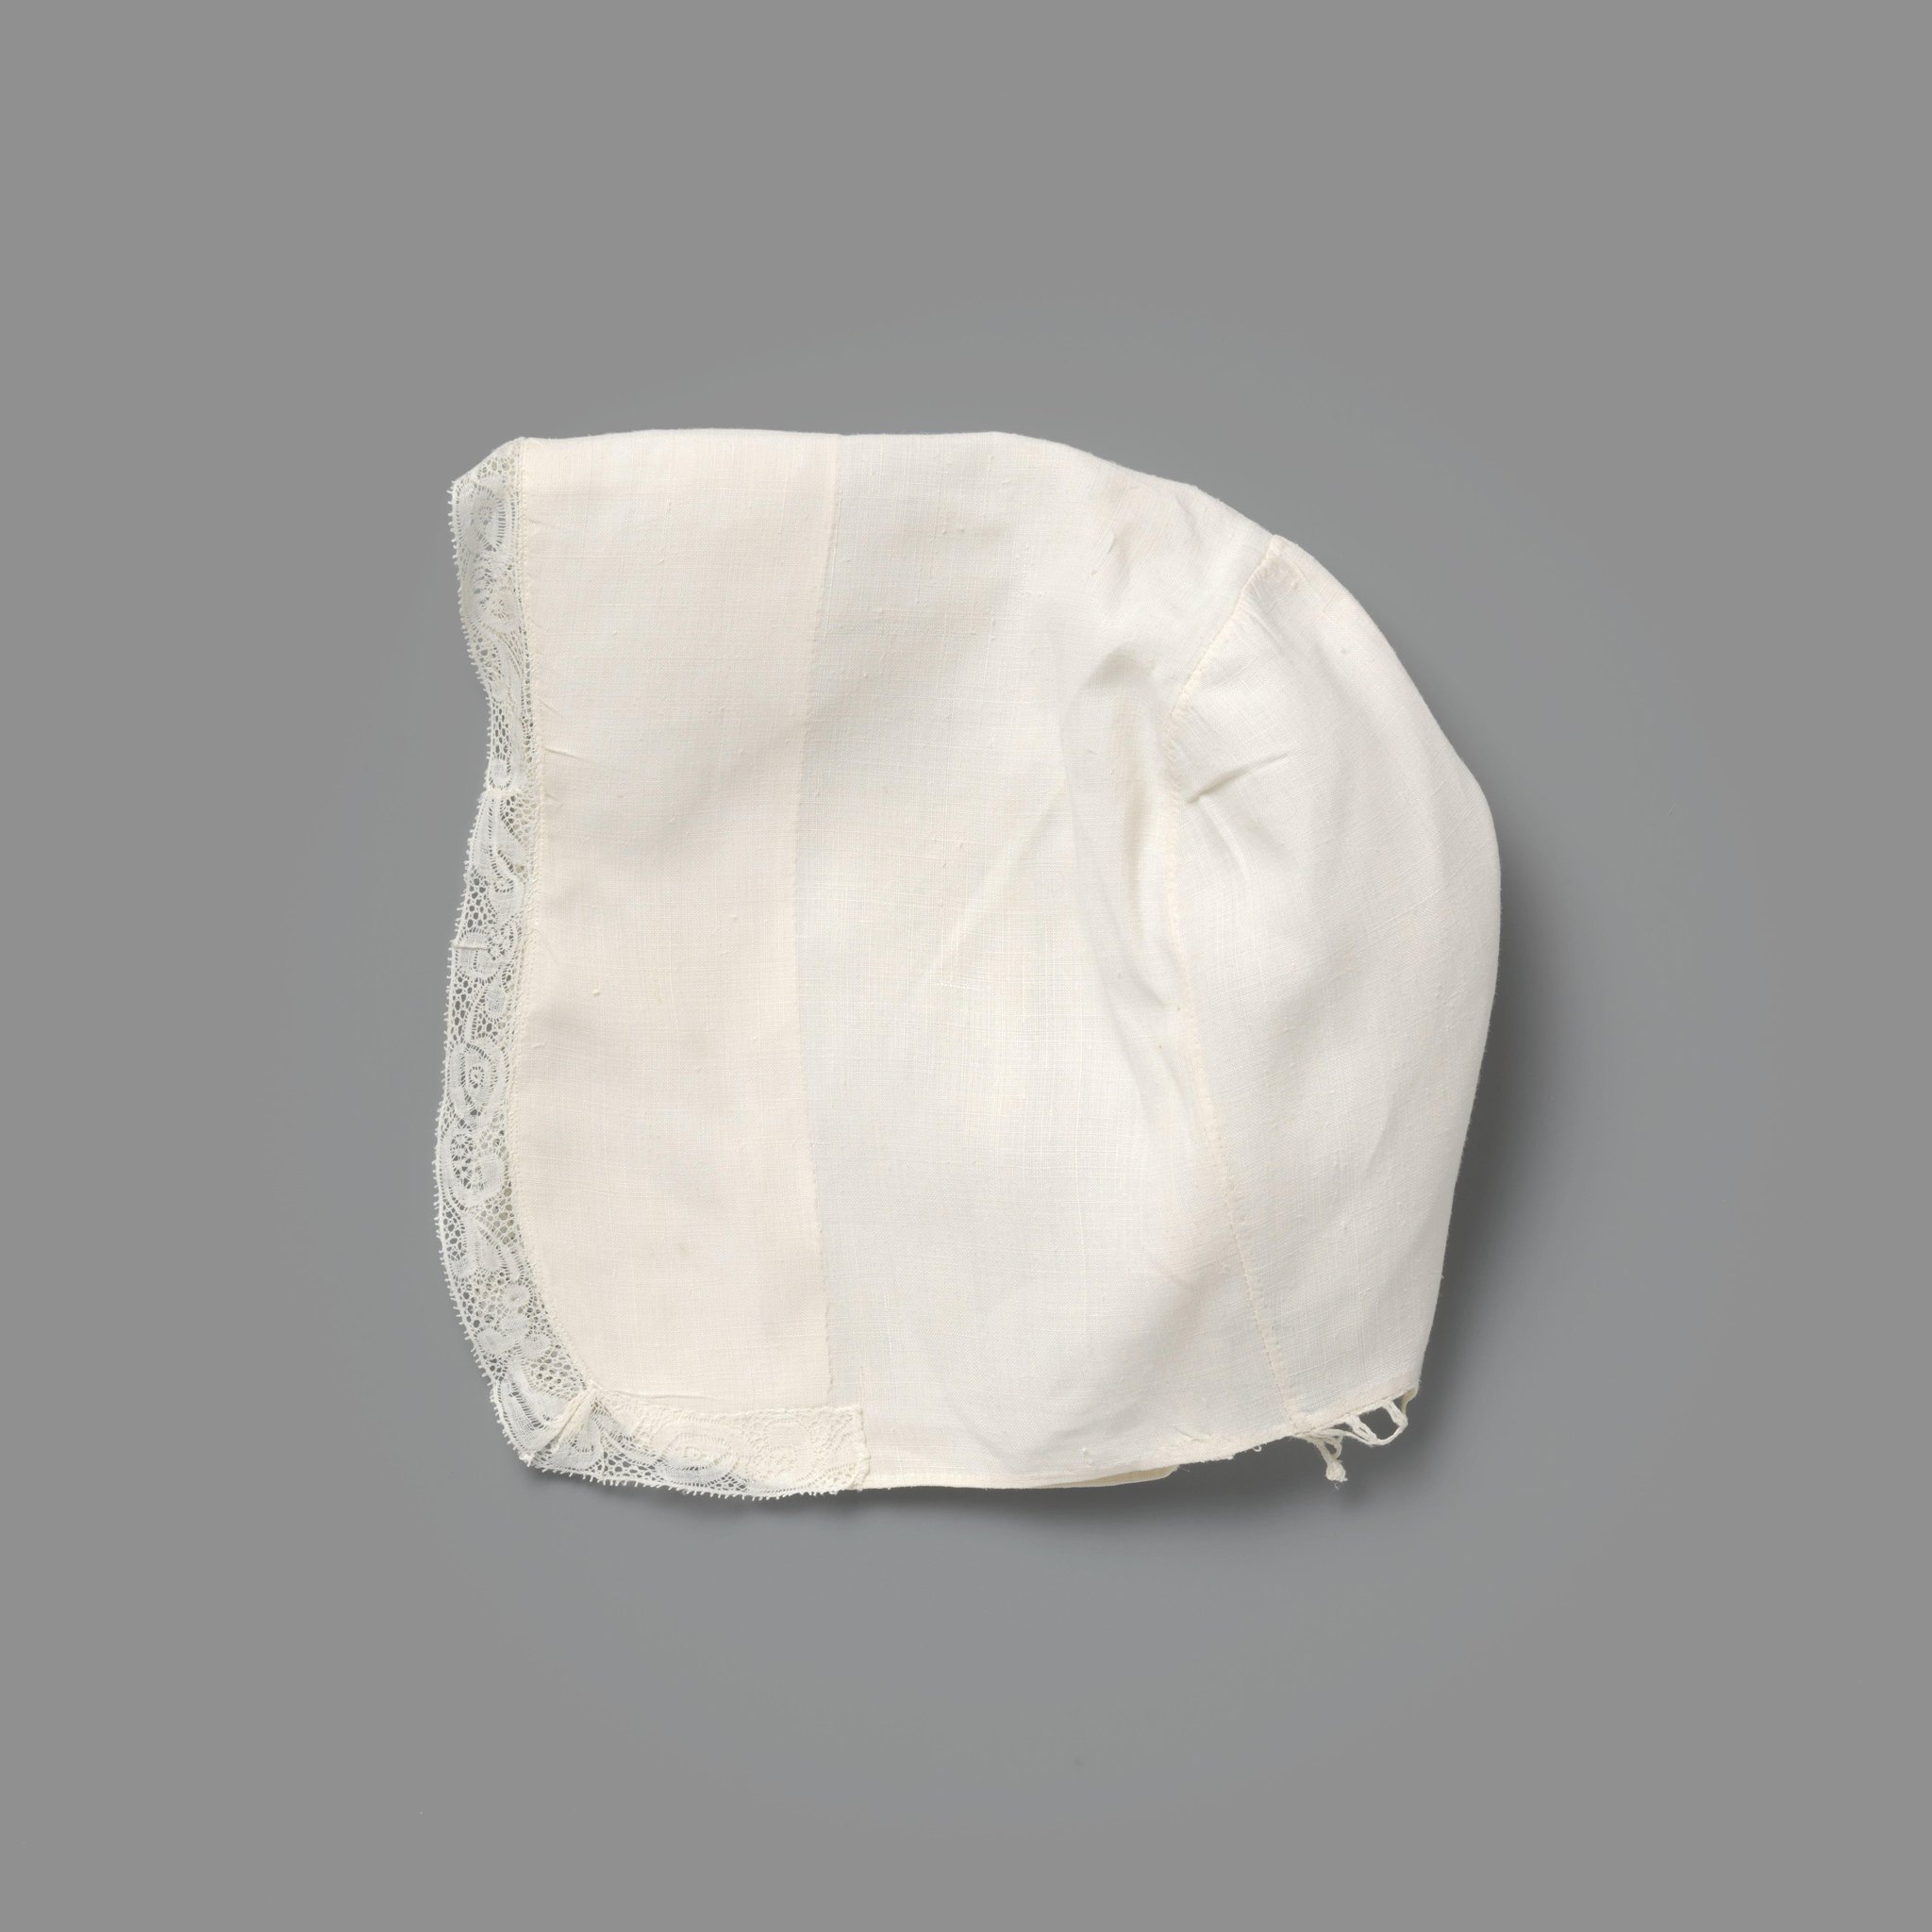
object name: hoofddeksel, hoofdbedekking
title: Kindermuts van linnen en Binchekant; gemerkt: S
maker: Anonymous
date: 1740-1760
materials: linen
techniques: lace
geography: netherlands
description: Een kindermuts van linnen en kloskant. in drie maten en gemerkt S. Model. Handgenaaid. Brede voorpas met de zoom tot op het midden daarvan. Hoefijzervormige bol. Aangenaalde vetertjes vormen busjes voor het achterste bantje. Slechts met één kinnebandje, dat terzijde wordt gespeld. d. Kant. Binche-kloskant met fond á cinq trous, met rechte picotrand en lopende rank met tulpenknopvormen.